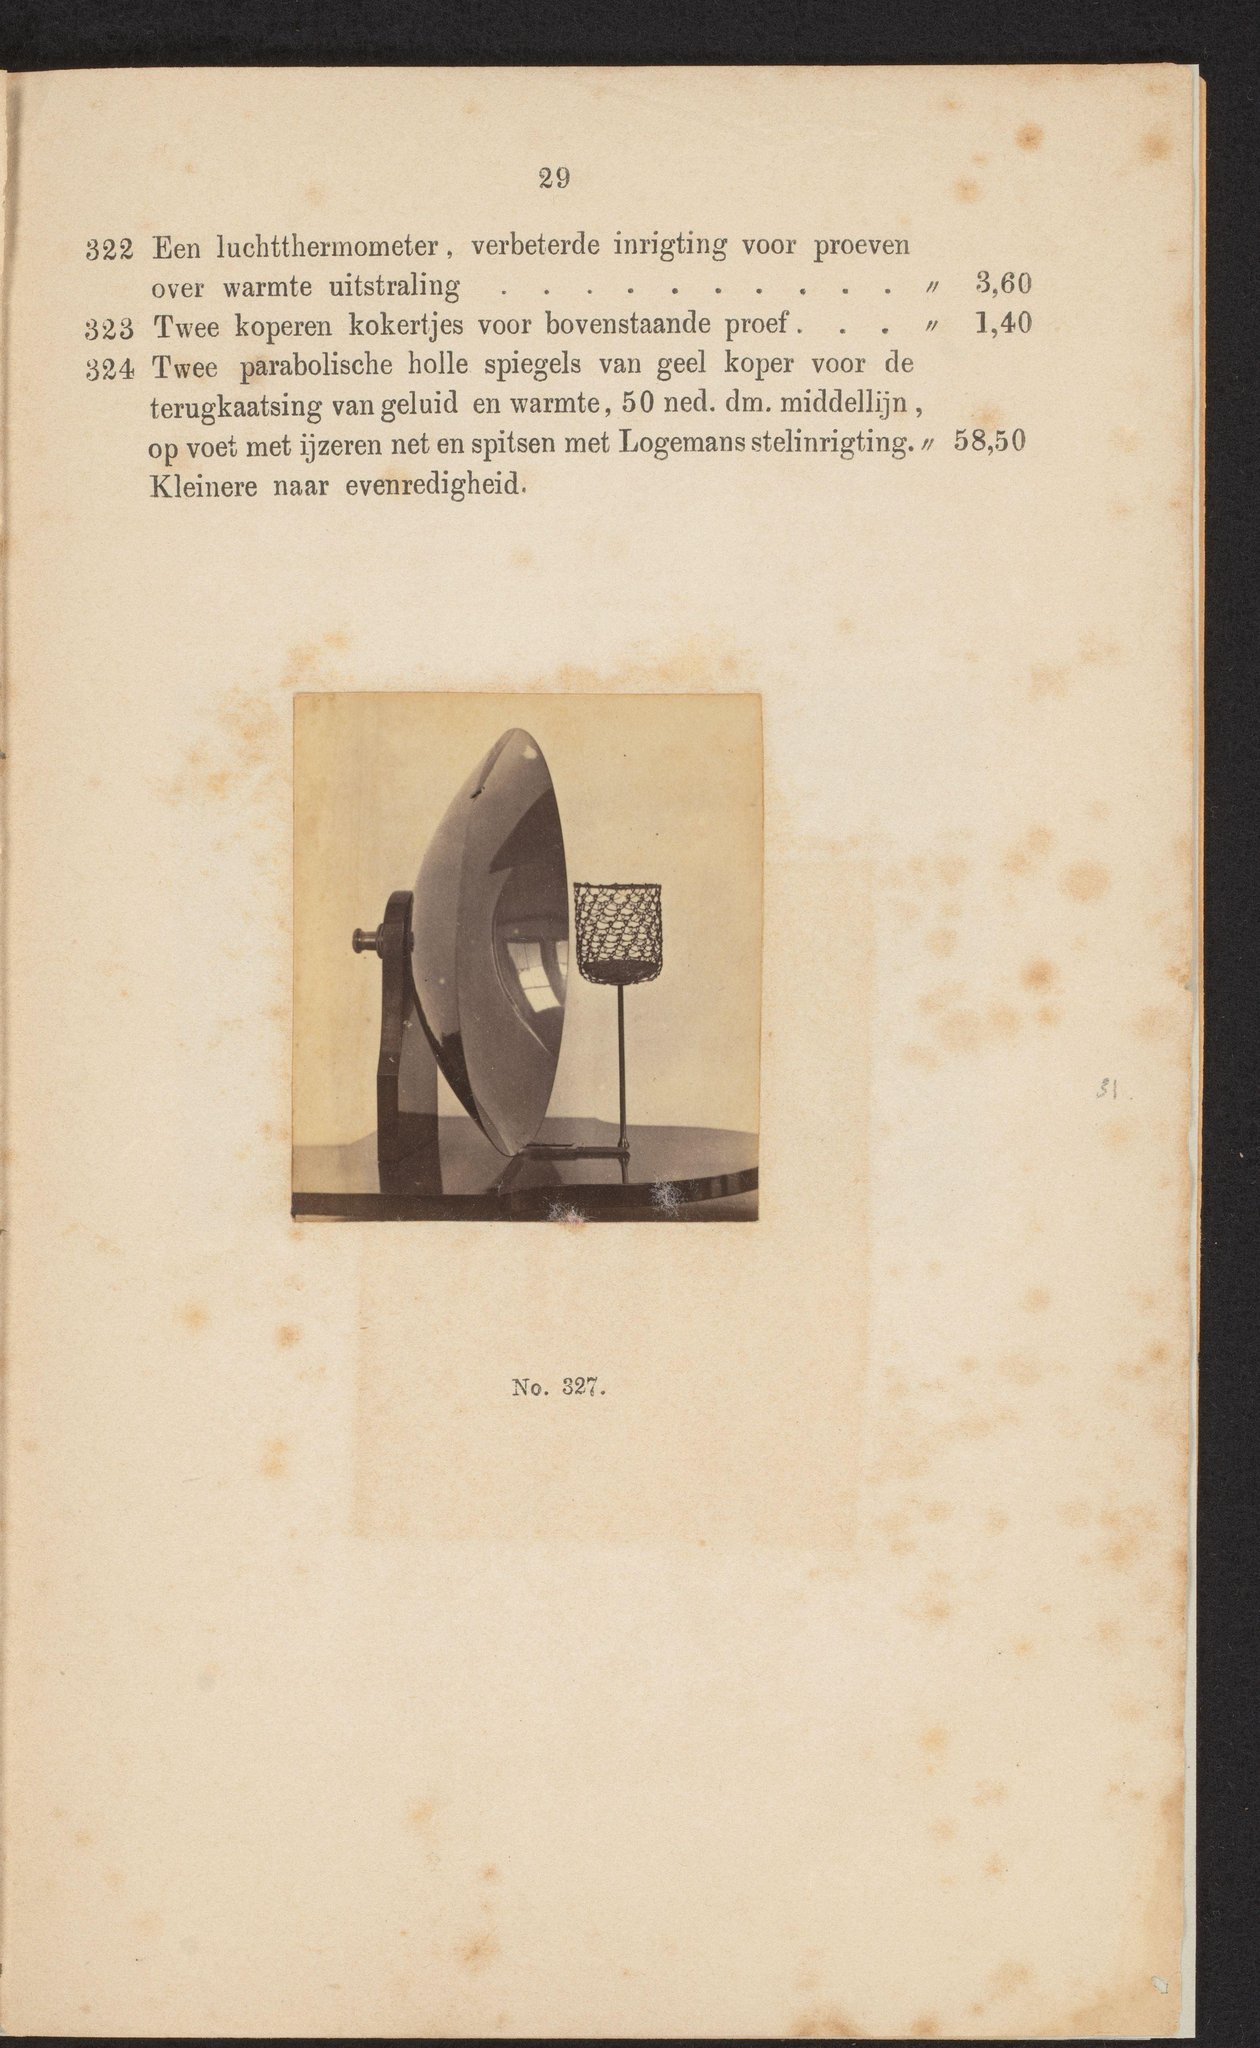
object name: page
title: Natuurkundig instrument met een holle spiegel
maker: fredrich wilhelm funckler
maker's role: instrument maker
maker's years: 1836-1886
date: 1857-1867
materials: photographic support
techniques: albumen print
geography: netherlands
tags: physics (+ tools, instruments; laboratory equipment ~ scientific research)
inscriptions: number: ‘No. 327.’